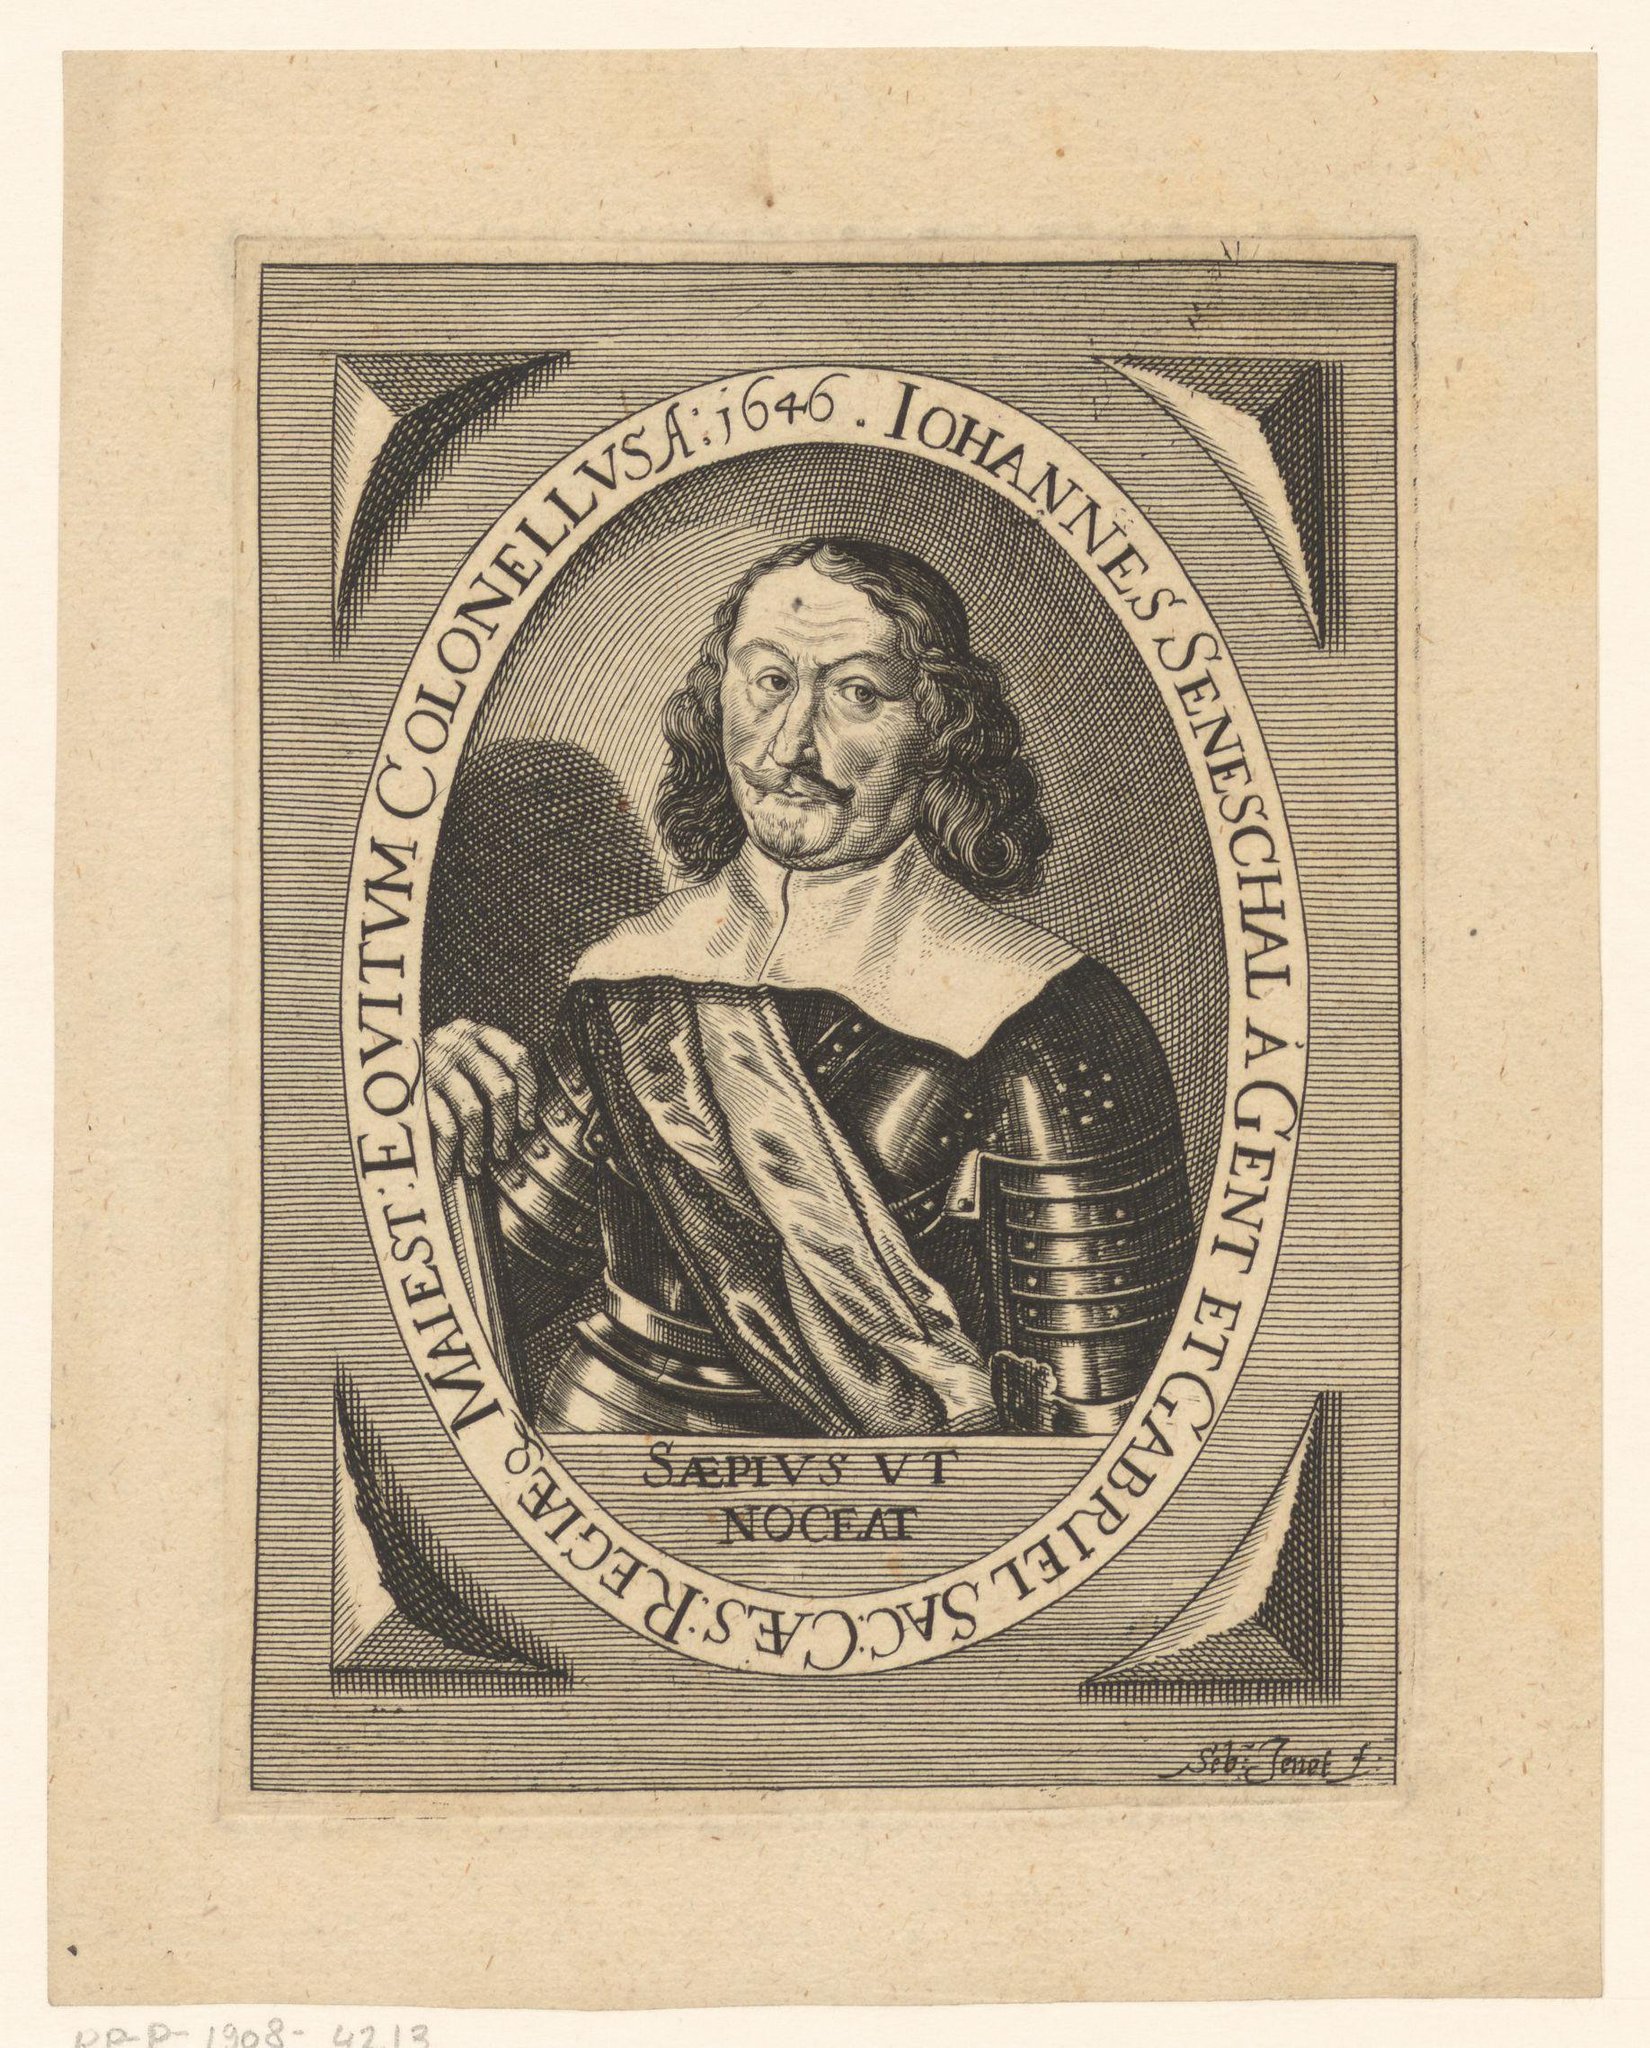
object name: print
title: Portret van Johann Seneschall von Gent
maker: sebastian jenet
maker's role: draughtsman, print maker, publisher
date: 1646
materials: paper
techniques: engraving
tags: historical persons, officer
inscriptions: collector's mark: Lugt 2228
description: Deze prent maakt deel uit van een serie van achttien portretten voor: Widemann, Elias. Comitium Gloriae Centum Qua Sanguine Qua Virtute Illustrium Heroum Iconibus Instructum Et Excelmo. Ac Illustrissimo Heroi D.D. Joanni Christophoro Com: a Puchaim (...) Dicatum. Wenen: Matthaeus Cosmerovius, 1650.